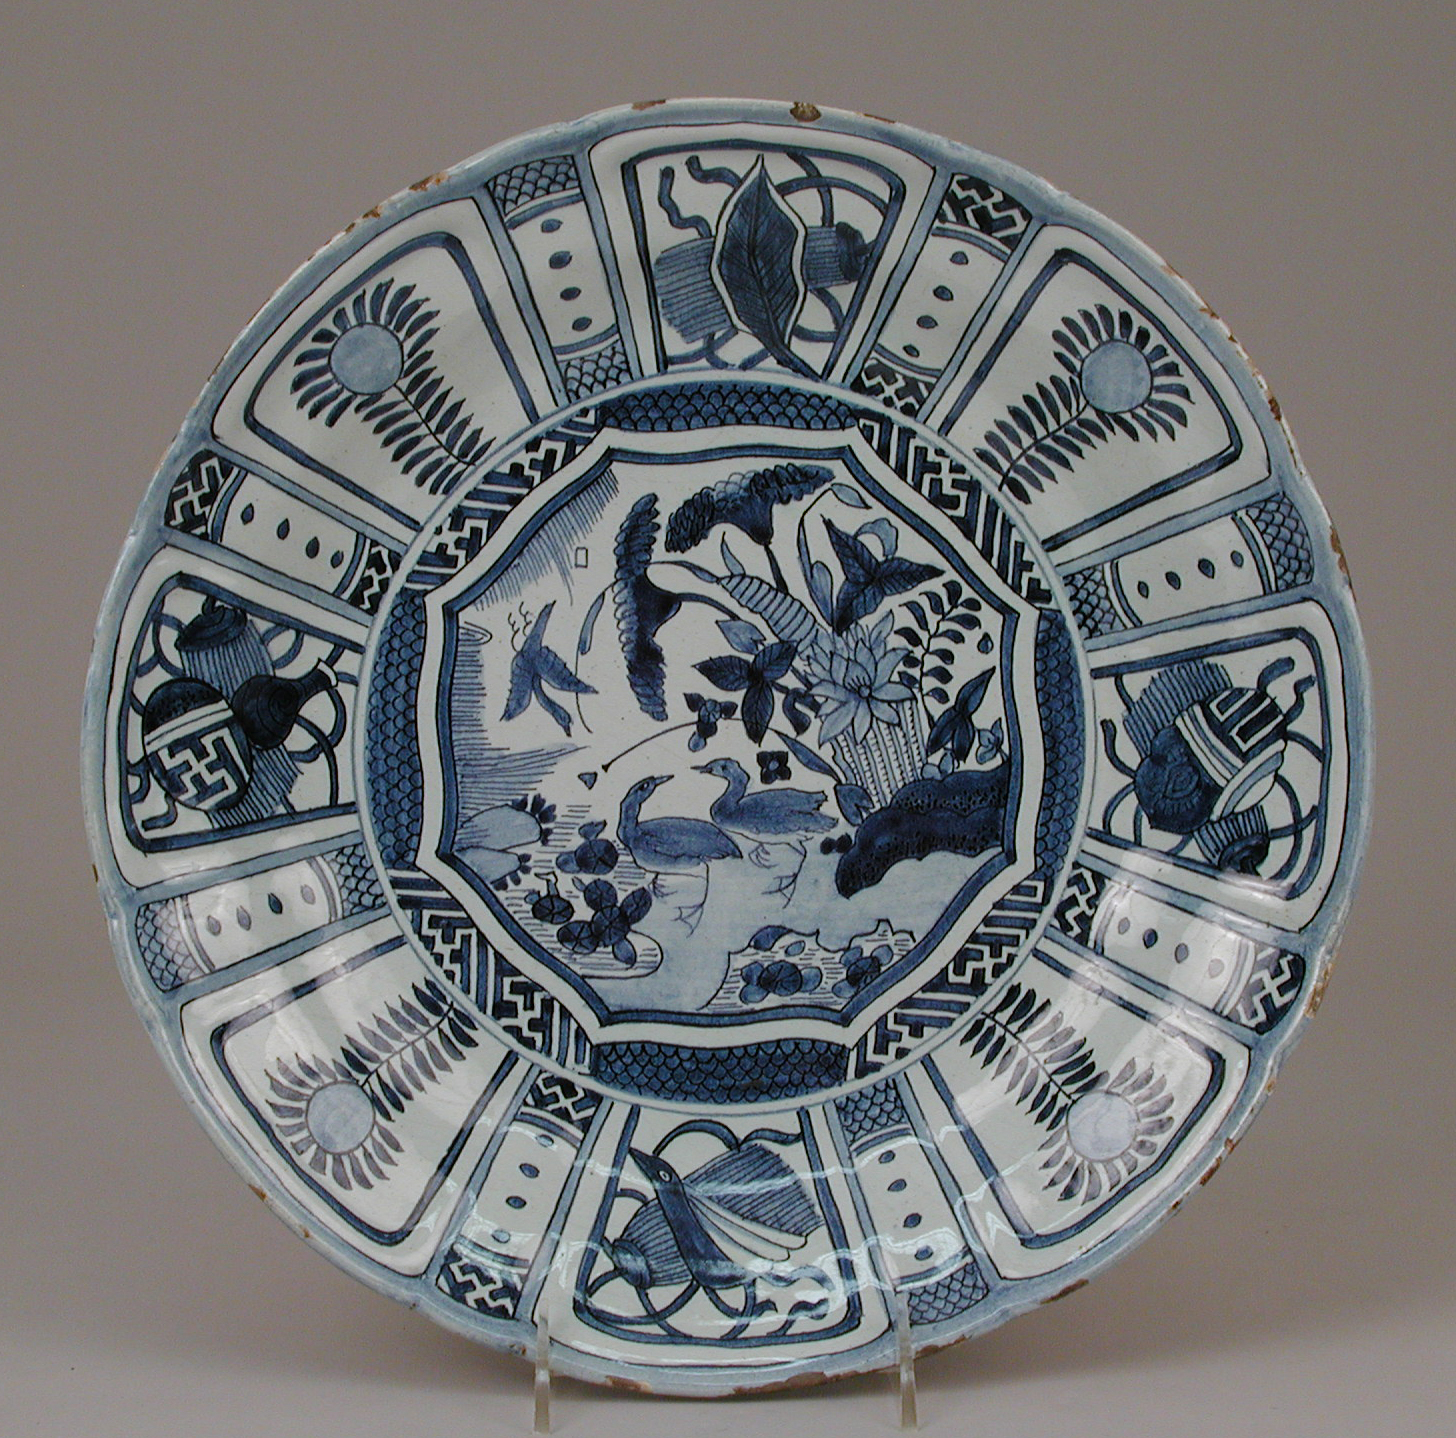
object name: dish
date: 1700-1730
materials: earthenware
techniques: glazing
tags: ducks,flowers